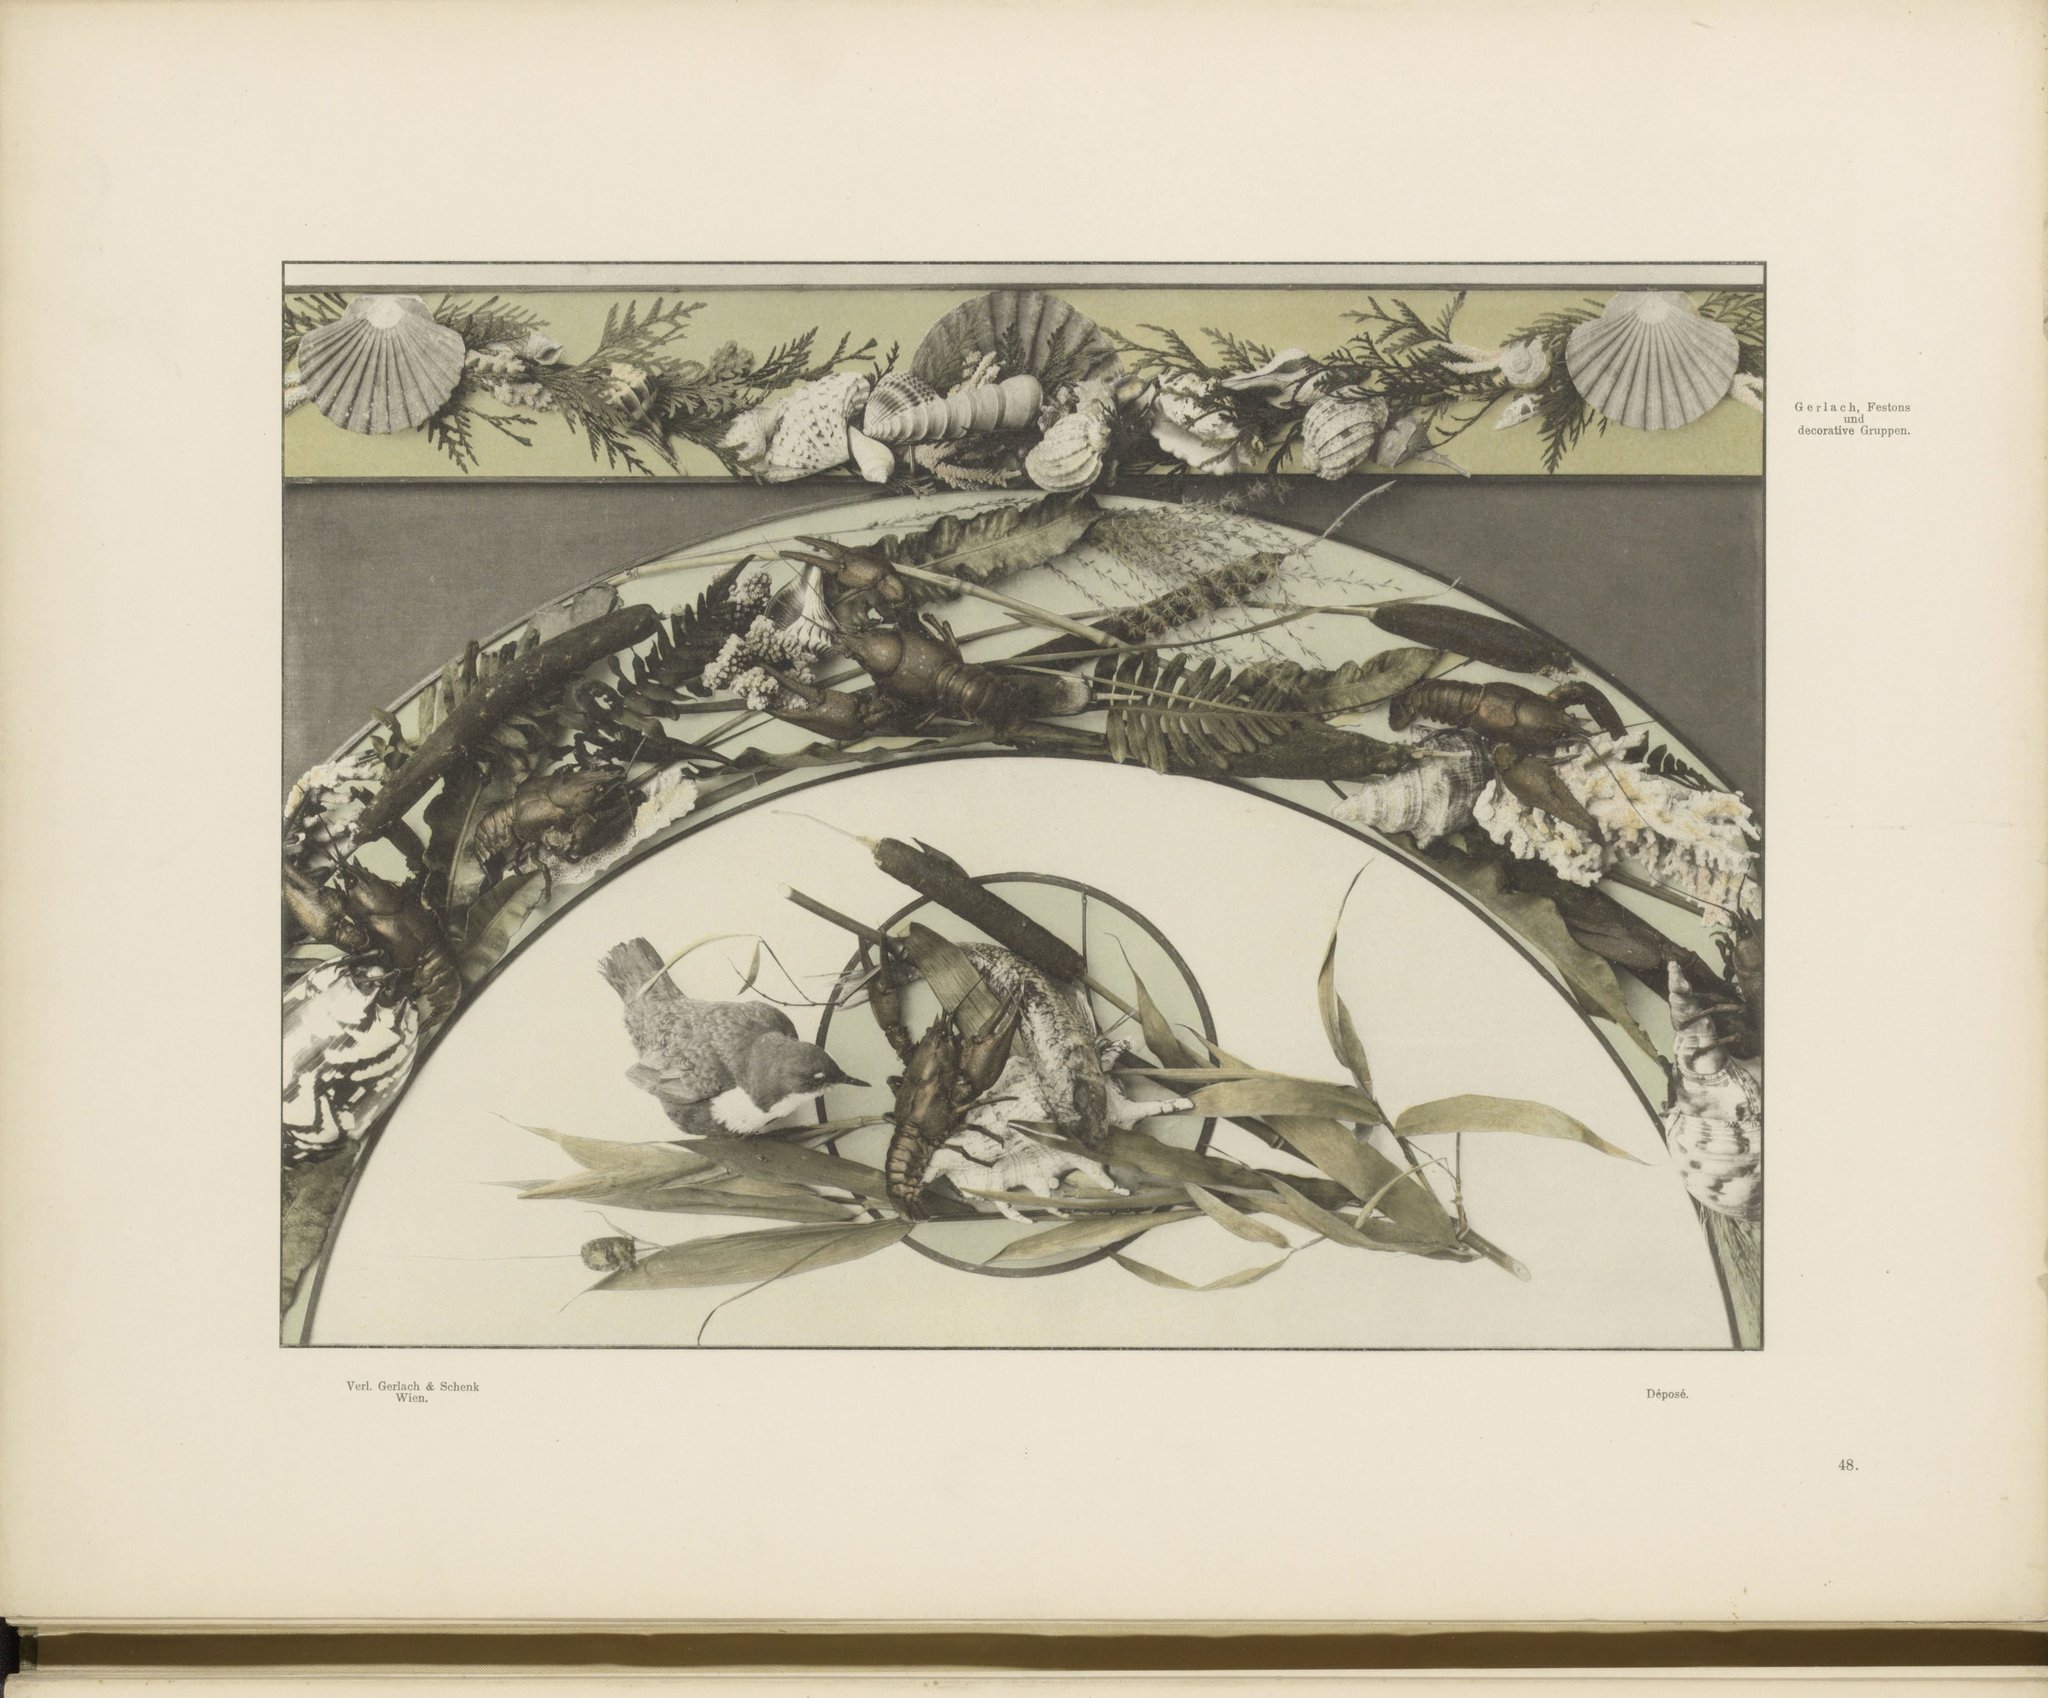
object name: page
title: Vlakken met schelpen, kreeften, varens en een vogel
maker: Anonymous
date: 1887-1897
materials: paper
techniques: photograph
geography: vienna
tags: ferns, birds, scallop, shell ~ ornament, crustaceans: lobster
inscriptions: number: ‘48.’